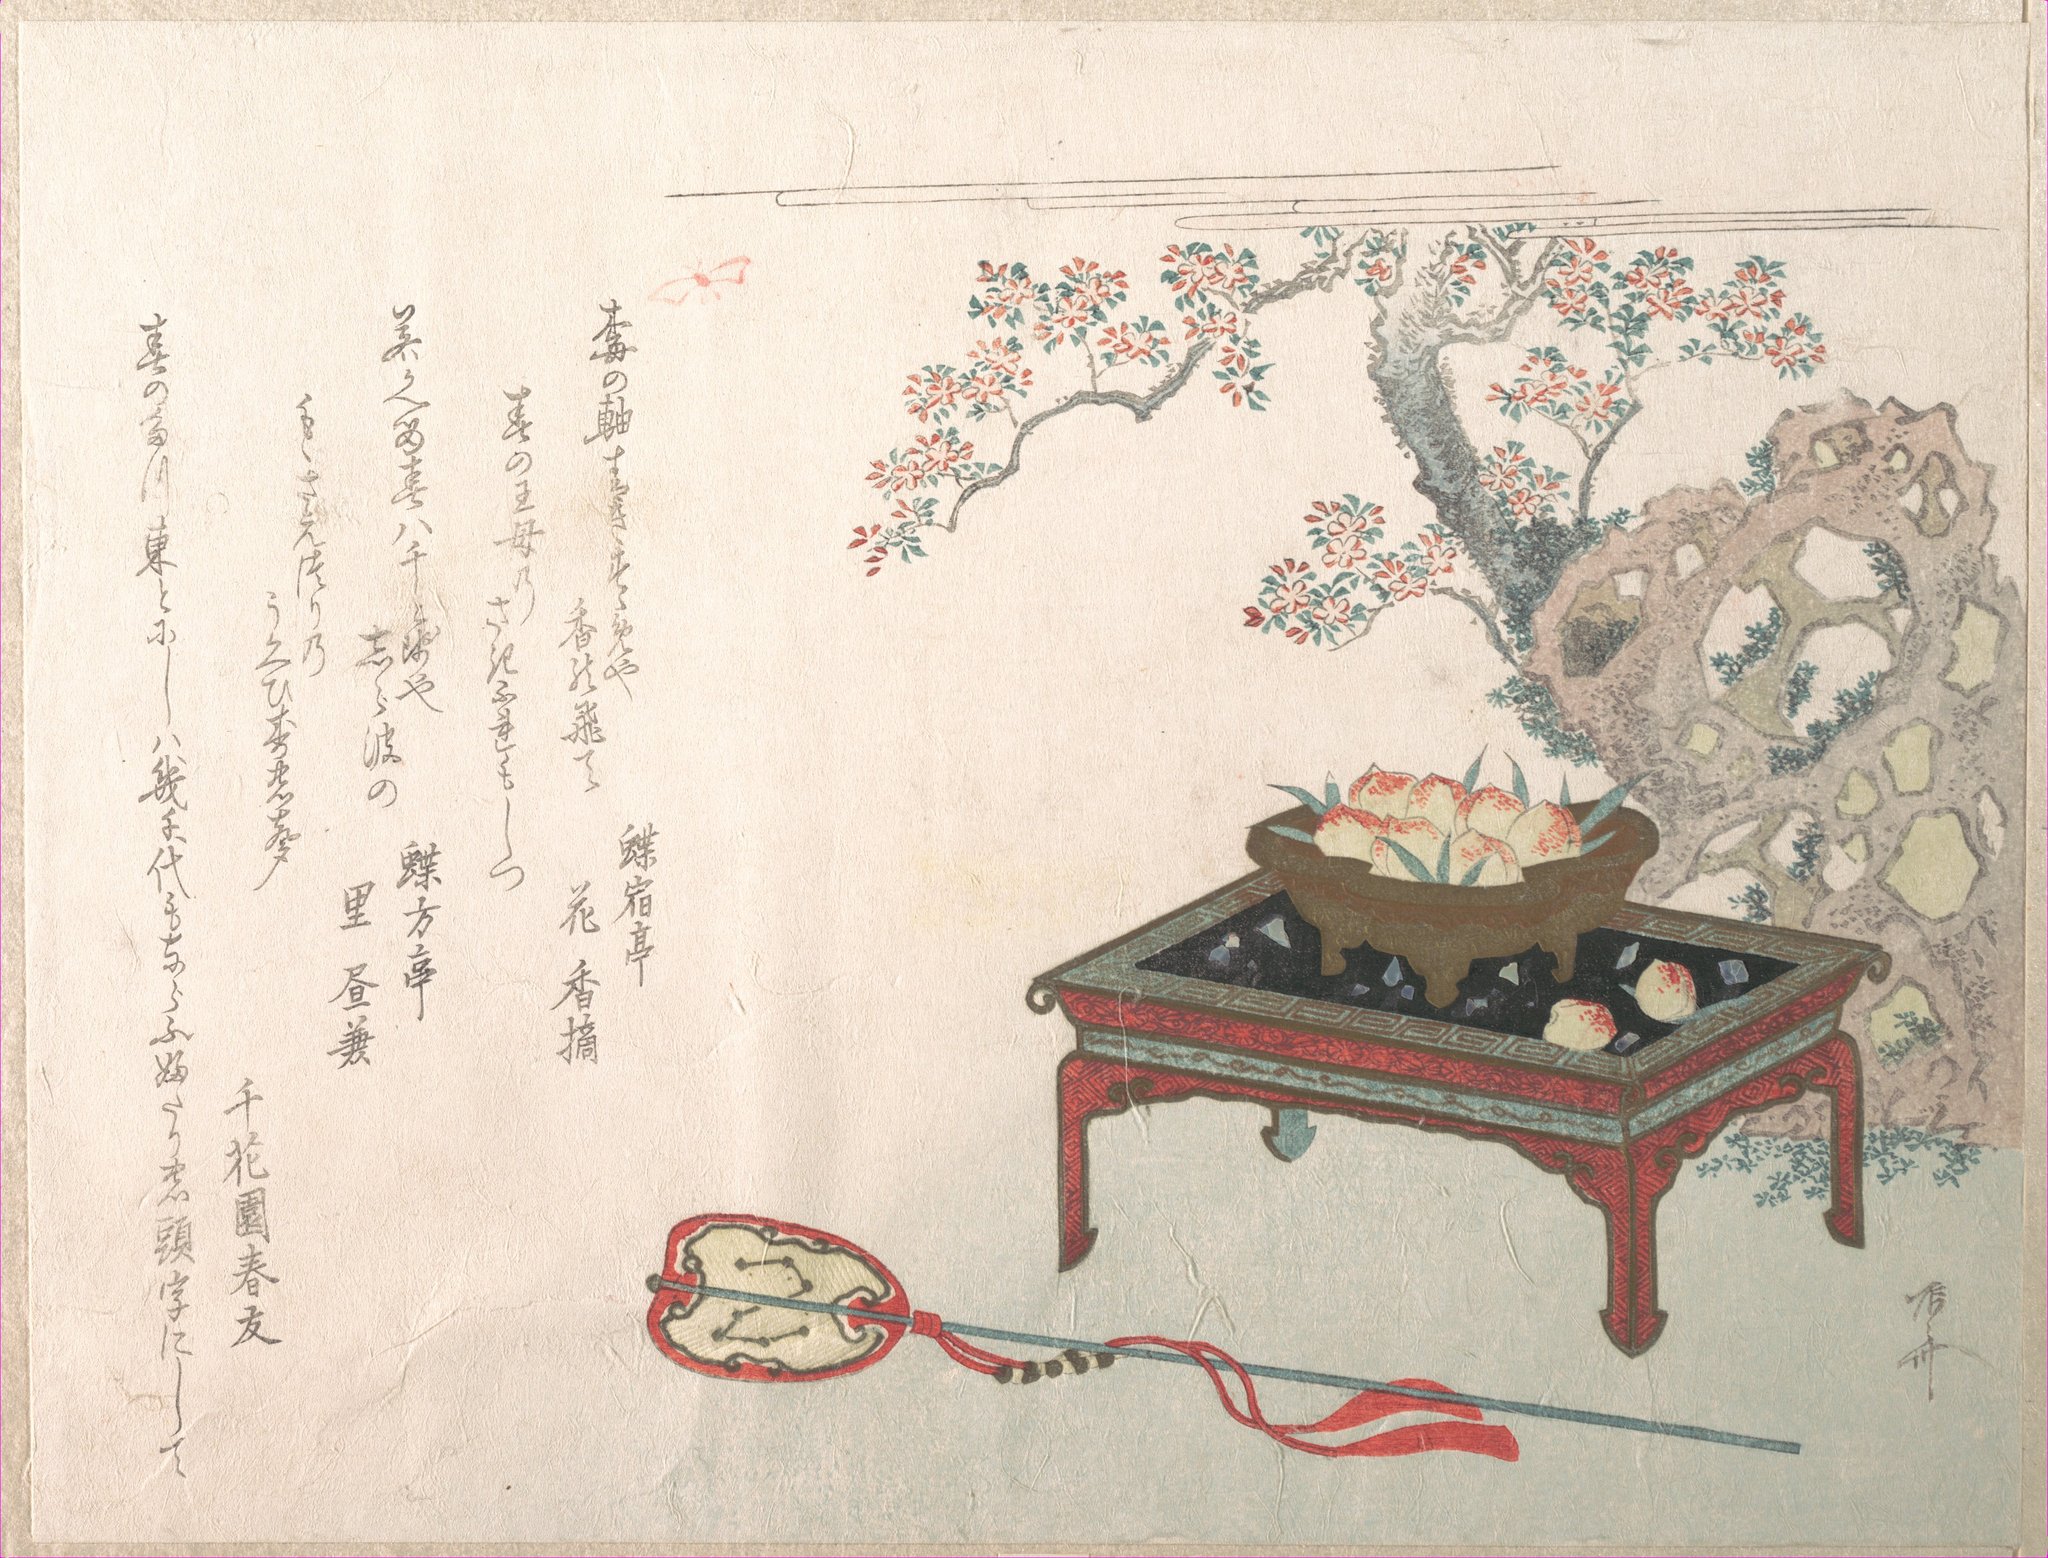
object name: print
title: Peaches on a Table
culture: japanese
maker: ryūryūkyo shinsai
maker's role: artist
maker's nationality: japanese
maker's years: 1799-1823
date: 1801-1900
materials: ink, paper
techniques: surimono, woodblock print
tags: peaches,trees,tables